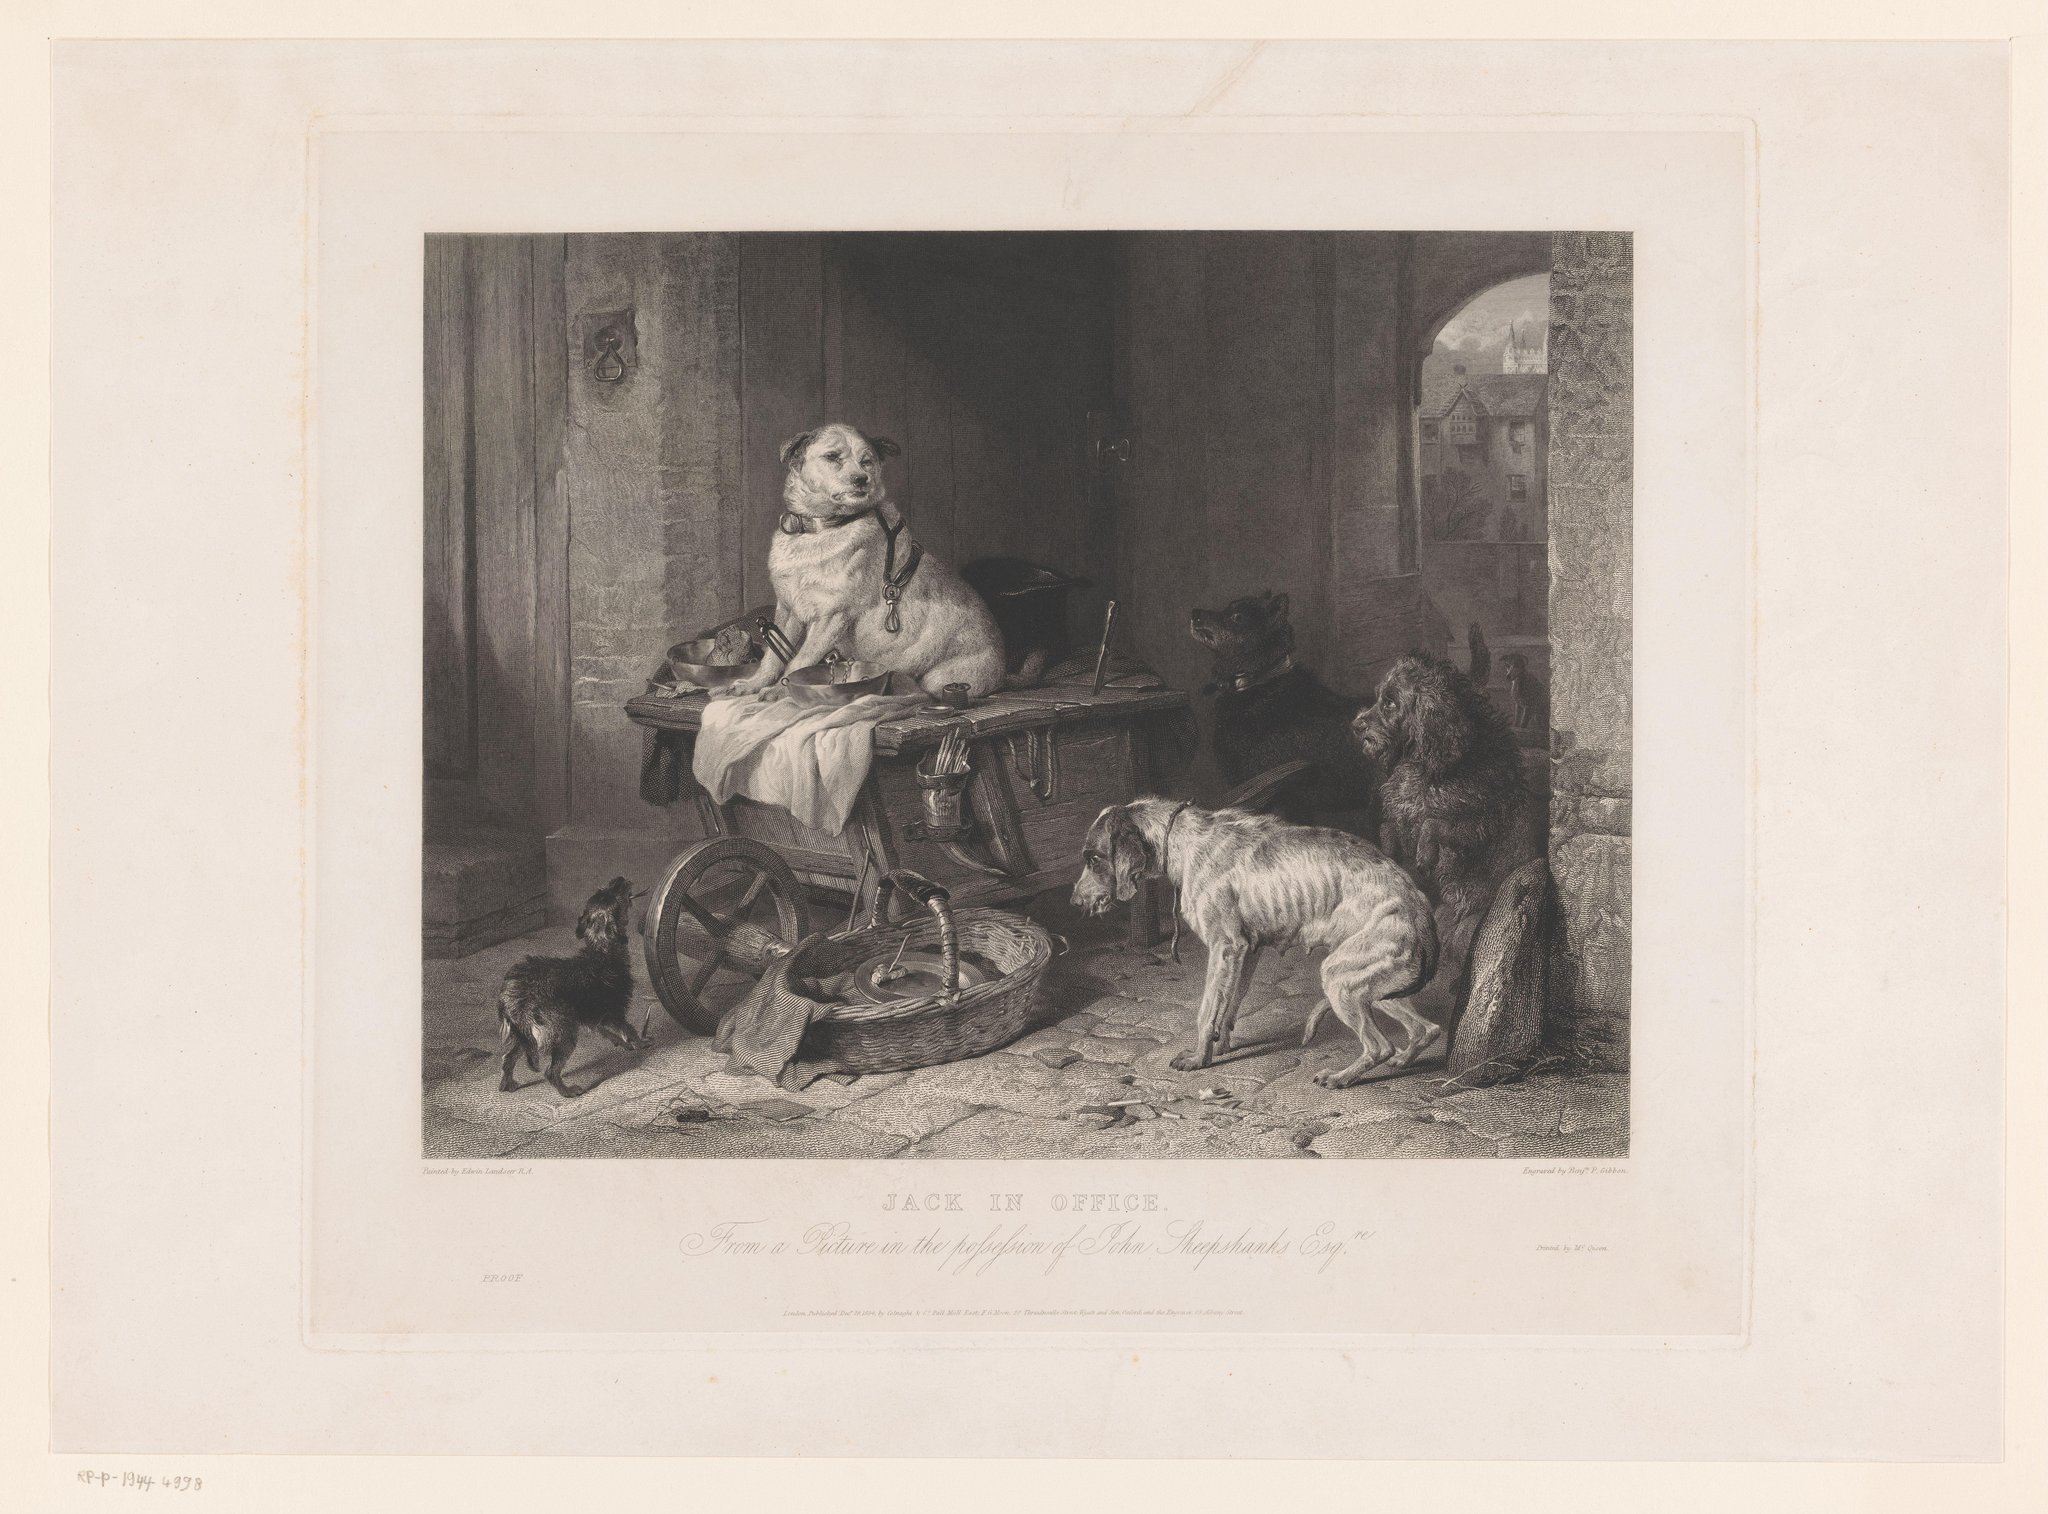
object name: print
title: Jack in Office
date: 1834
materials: paper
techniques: engraving, etching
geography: london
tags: hierarchical order, dog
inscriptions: collector's mark: Lugt 2228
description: Tekst in het Engels in de ondermarge. De Jack Russell op de kruiwagen is de dominante hond. De verhoudingen tussen de honden lijken een afspiegeling van de samenleving.